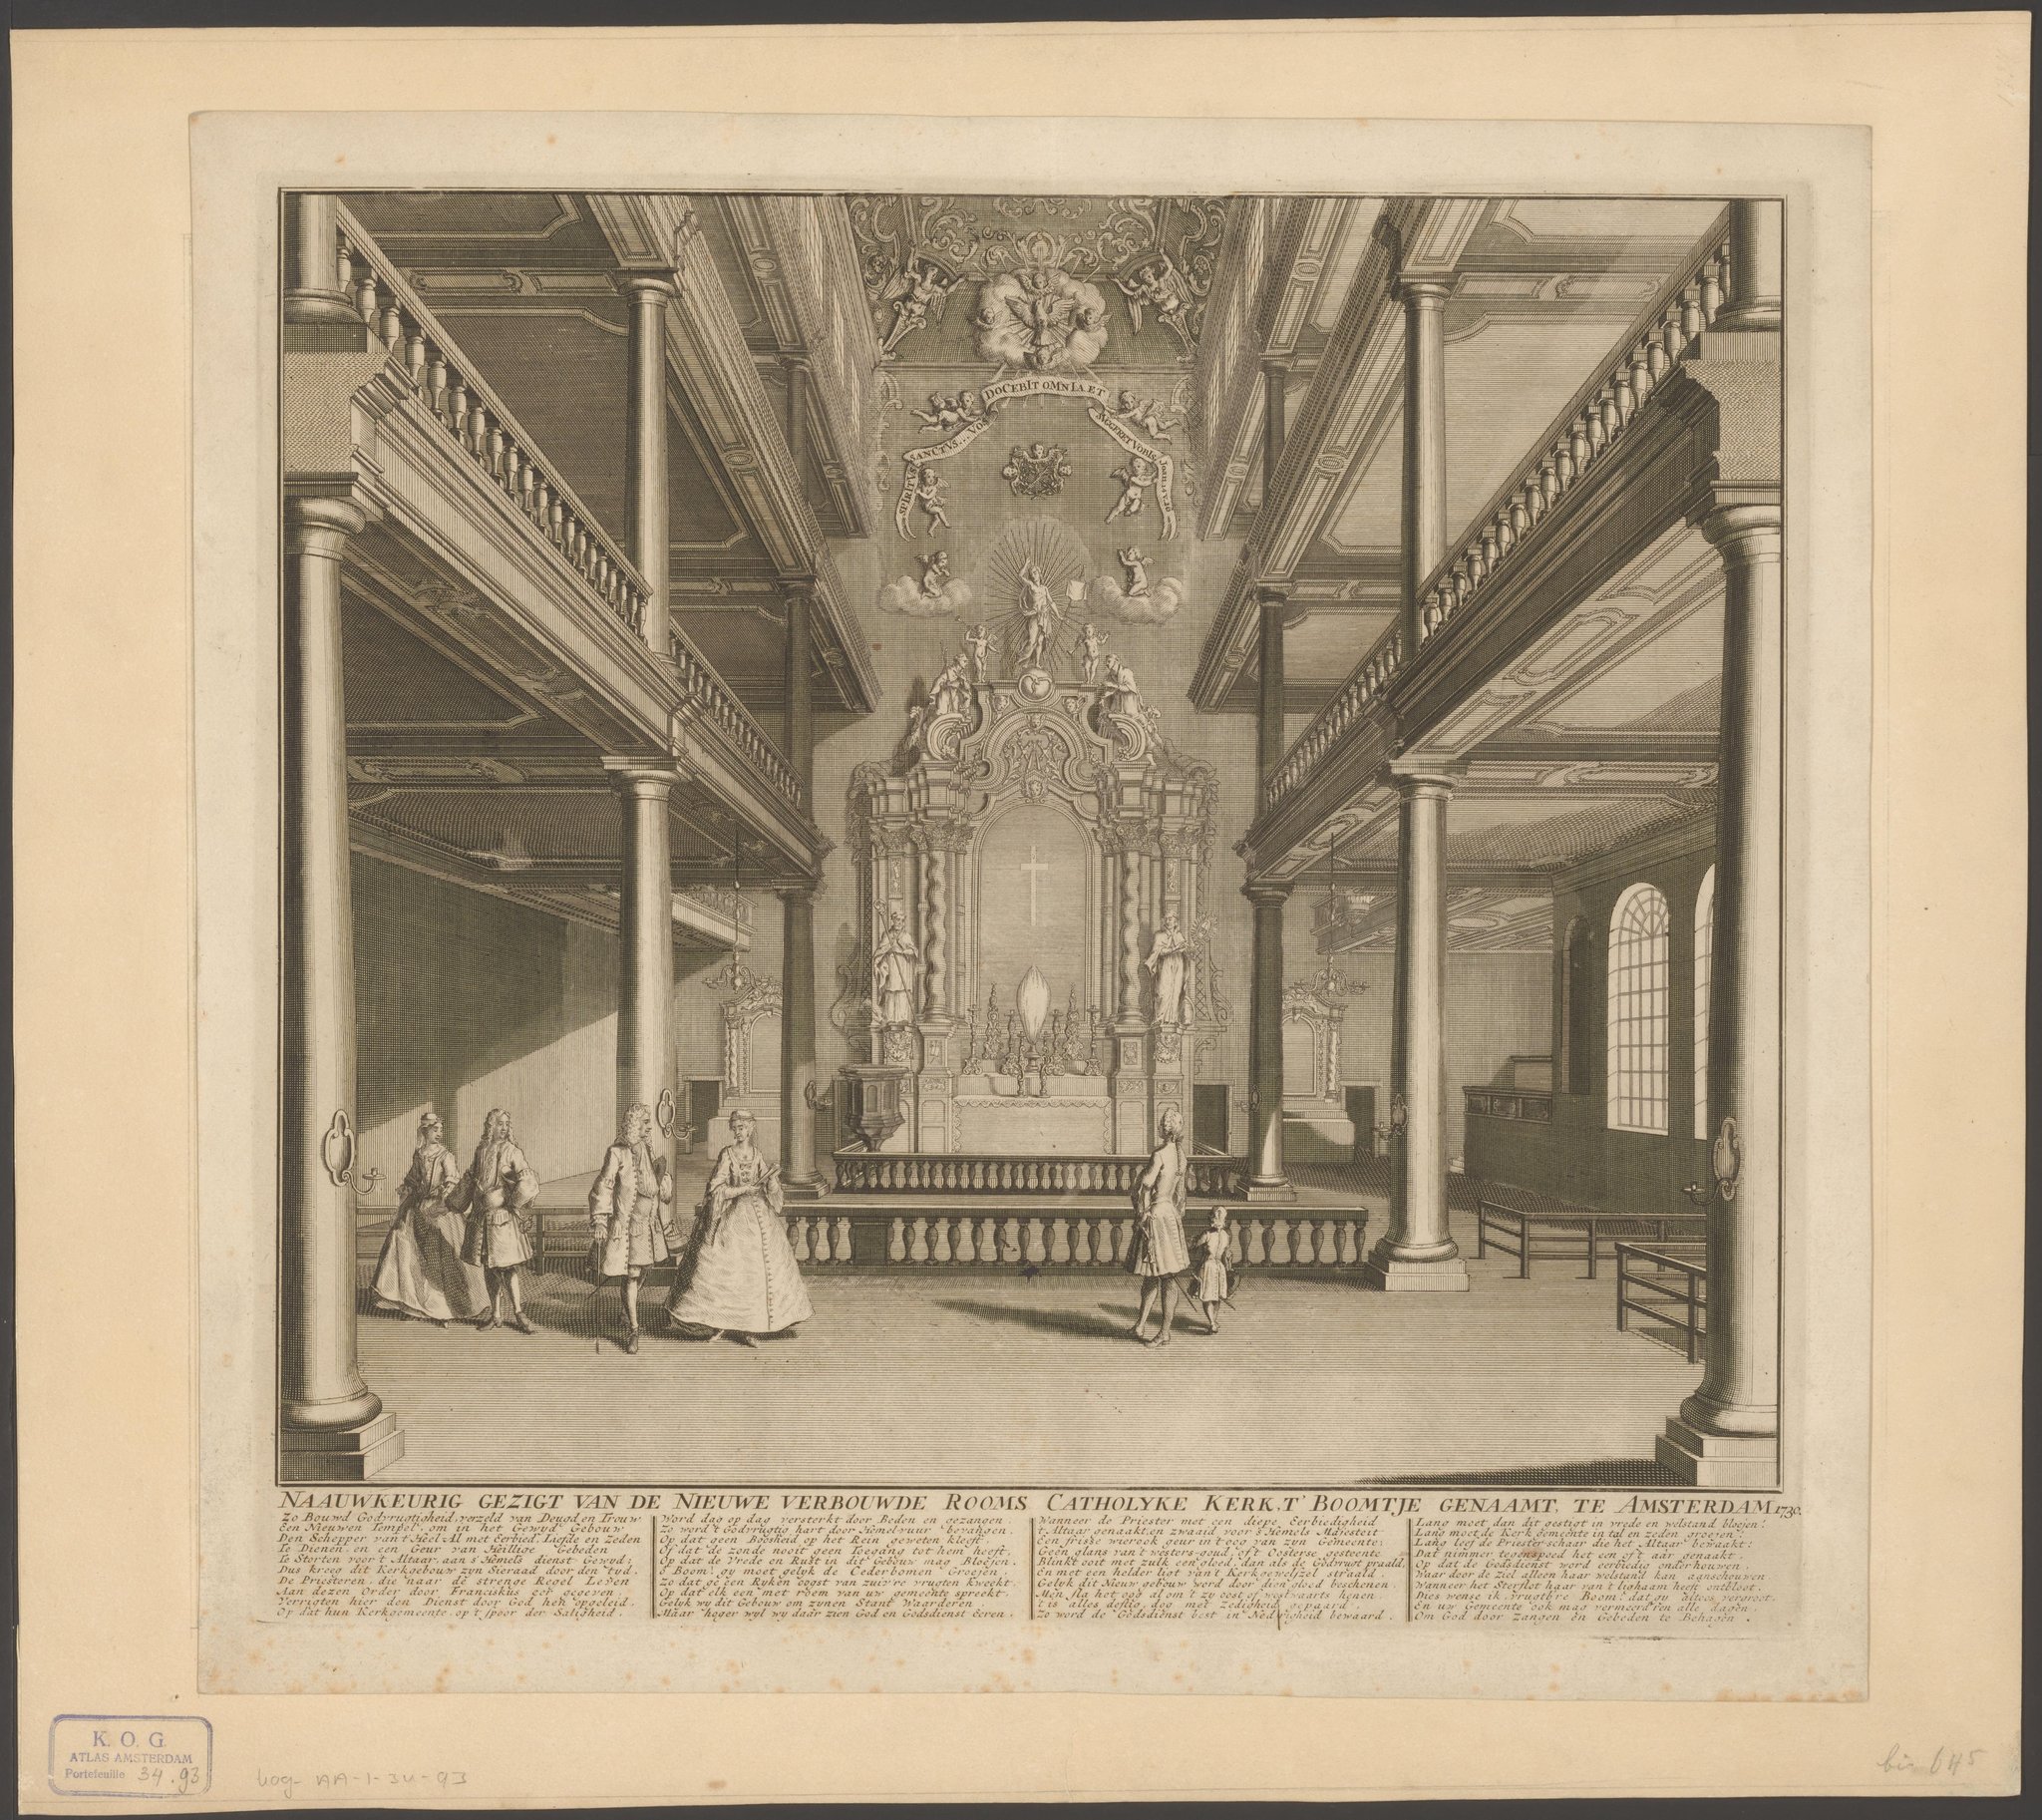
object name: print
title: Interieur van de rooms-katholieke schuilkerk Het Boompje te Amsterdam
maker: Anonymous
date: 1730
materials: paper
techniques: engraving, etching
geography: northern netherlands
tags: interior of church, altar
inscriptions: collector's mark: Lugt 1641b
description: Onderwerpsrubriek binnen de Atlas Amsterdam: Kerkwezen: R.K. Gemeenten: Begijnhof t/m Petrus en Paulus.